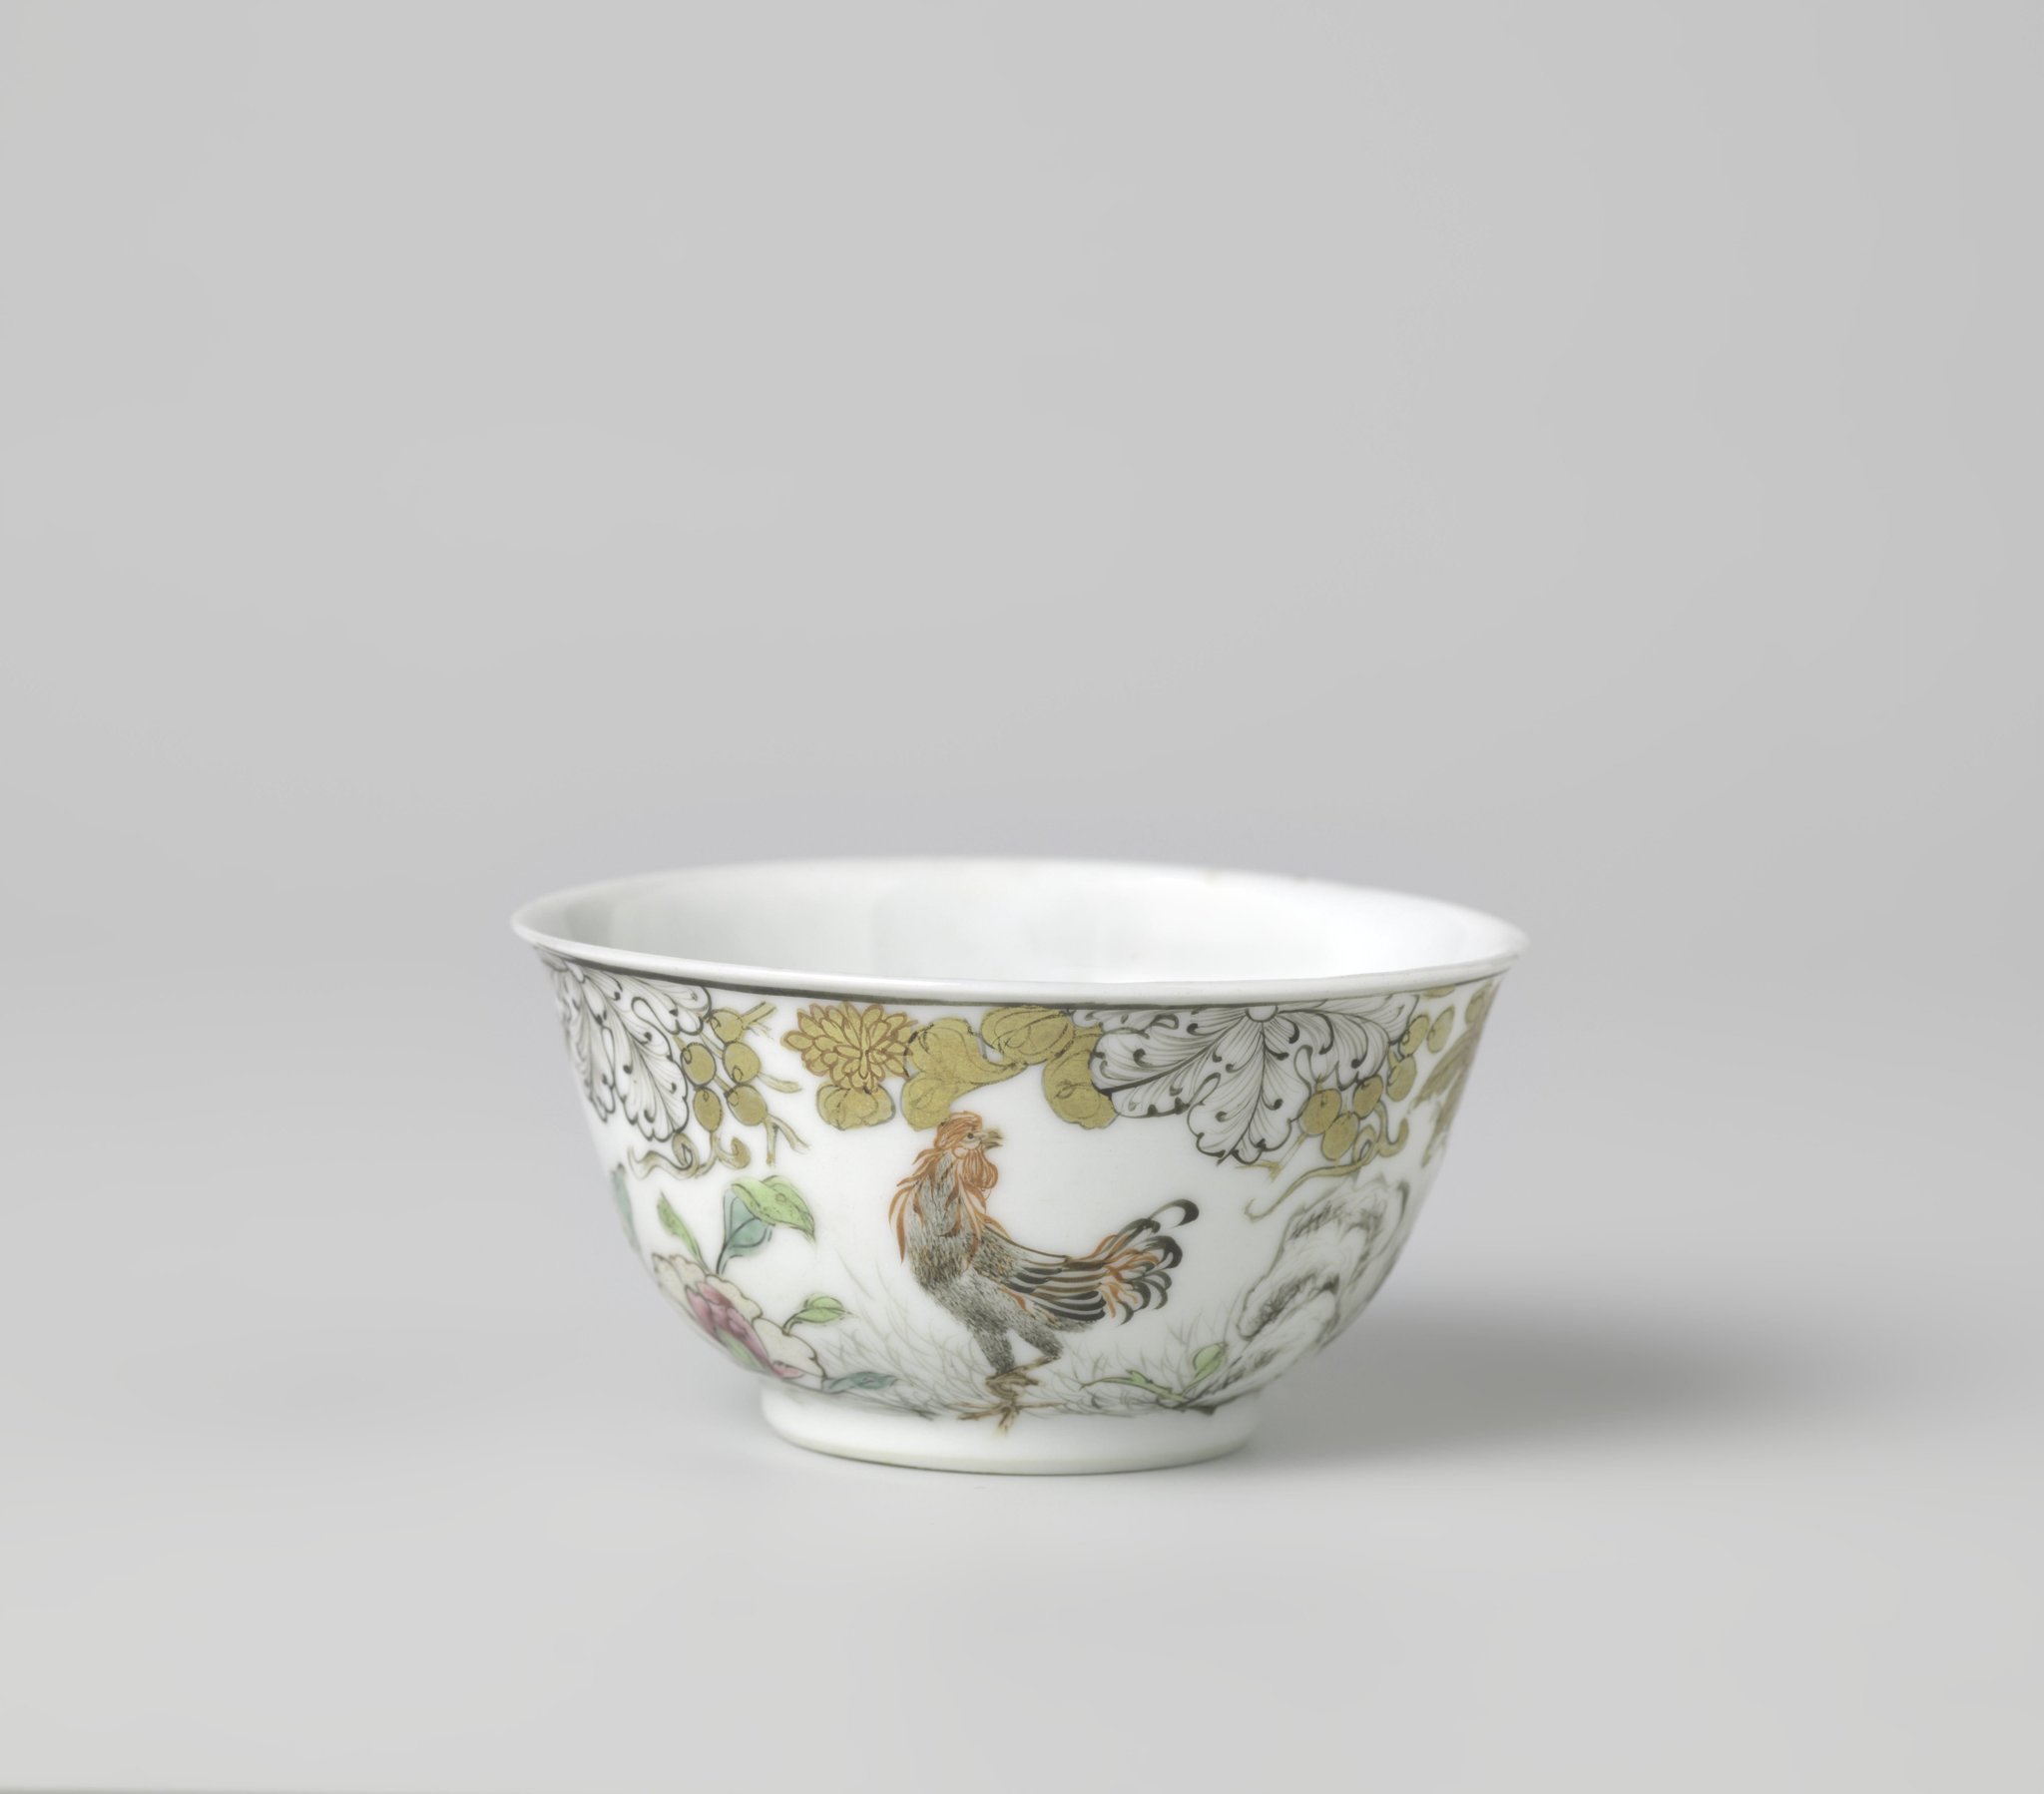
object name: cup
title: Bell-shaped cup with a cock near rocks with flowering plants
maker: Anonymous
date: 1725-1749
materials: glaze, gold, paint, porcelain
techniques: firing, gilding, turning, vitrification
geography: china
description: Kop, versierd met haan en bloemen in zwart goud en kleuren.